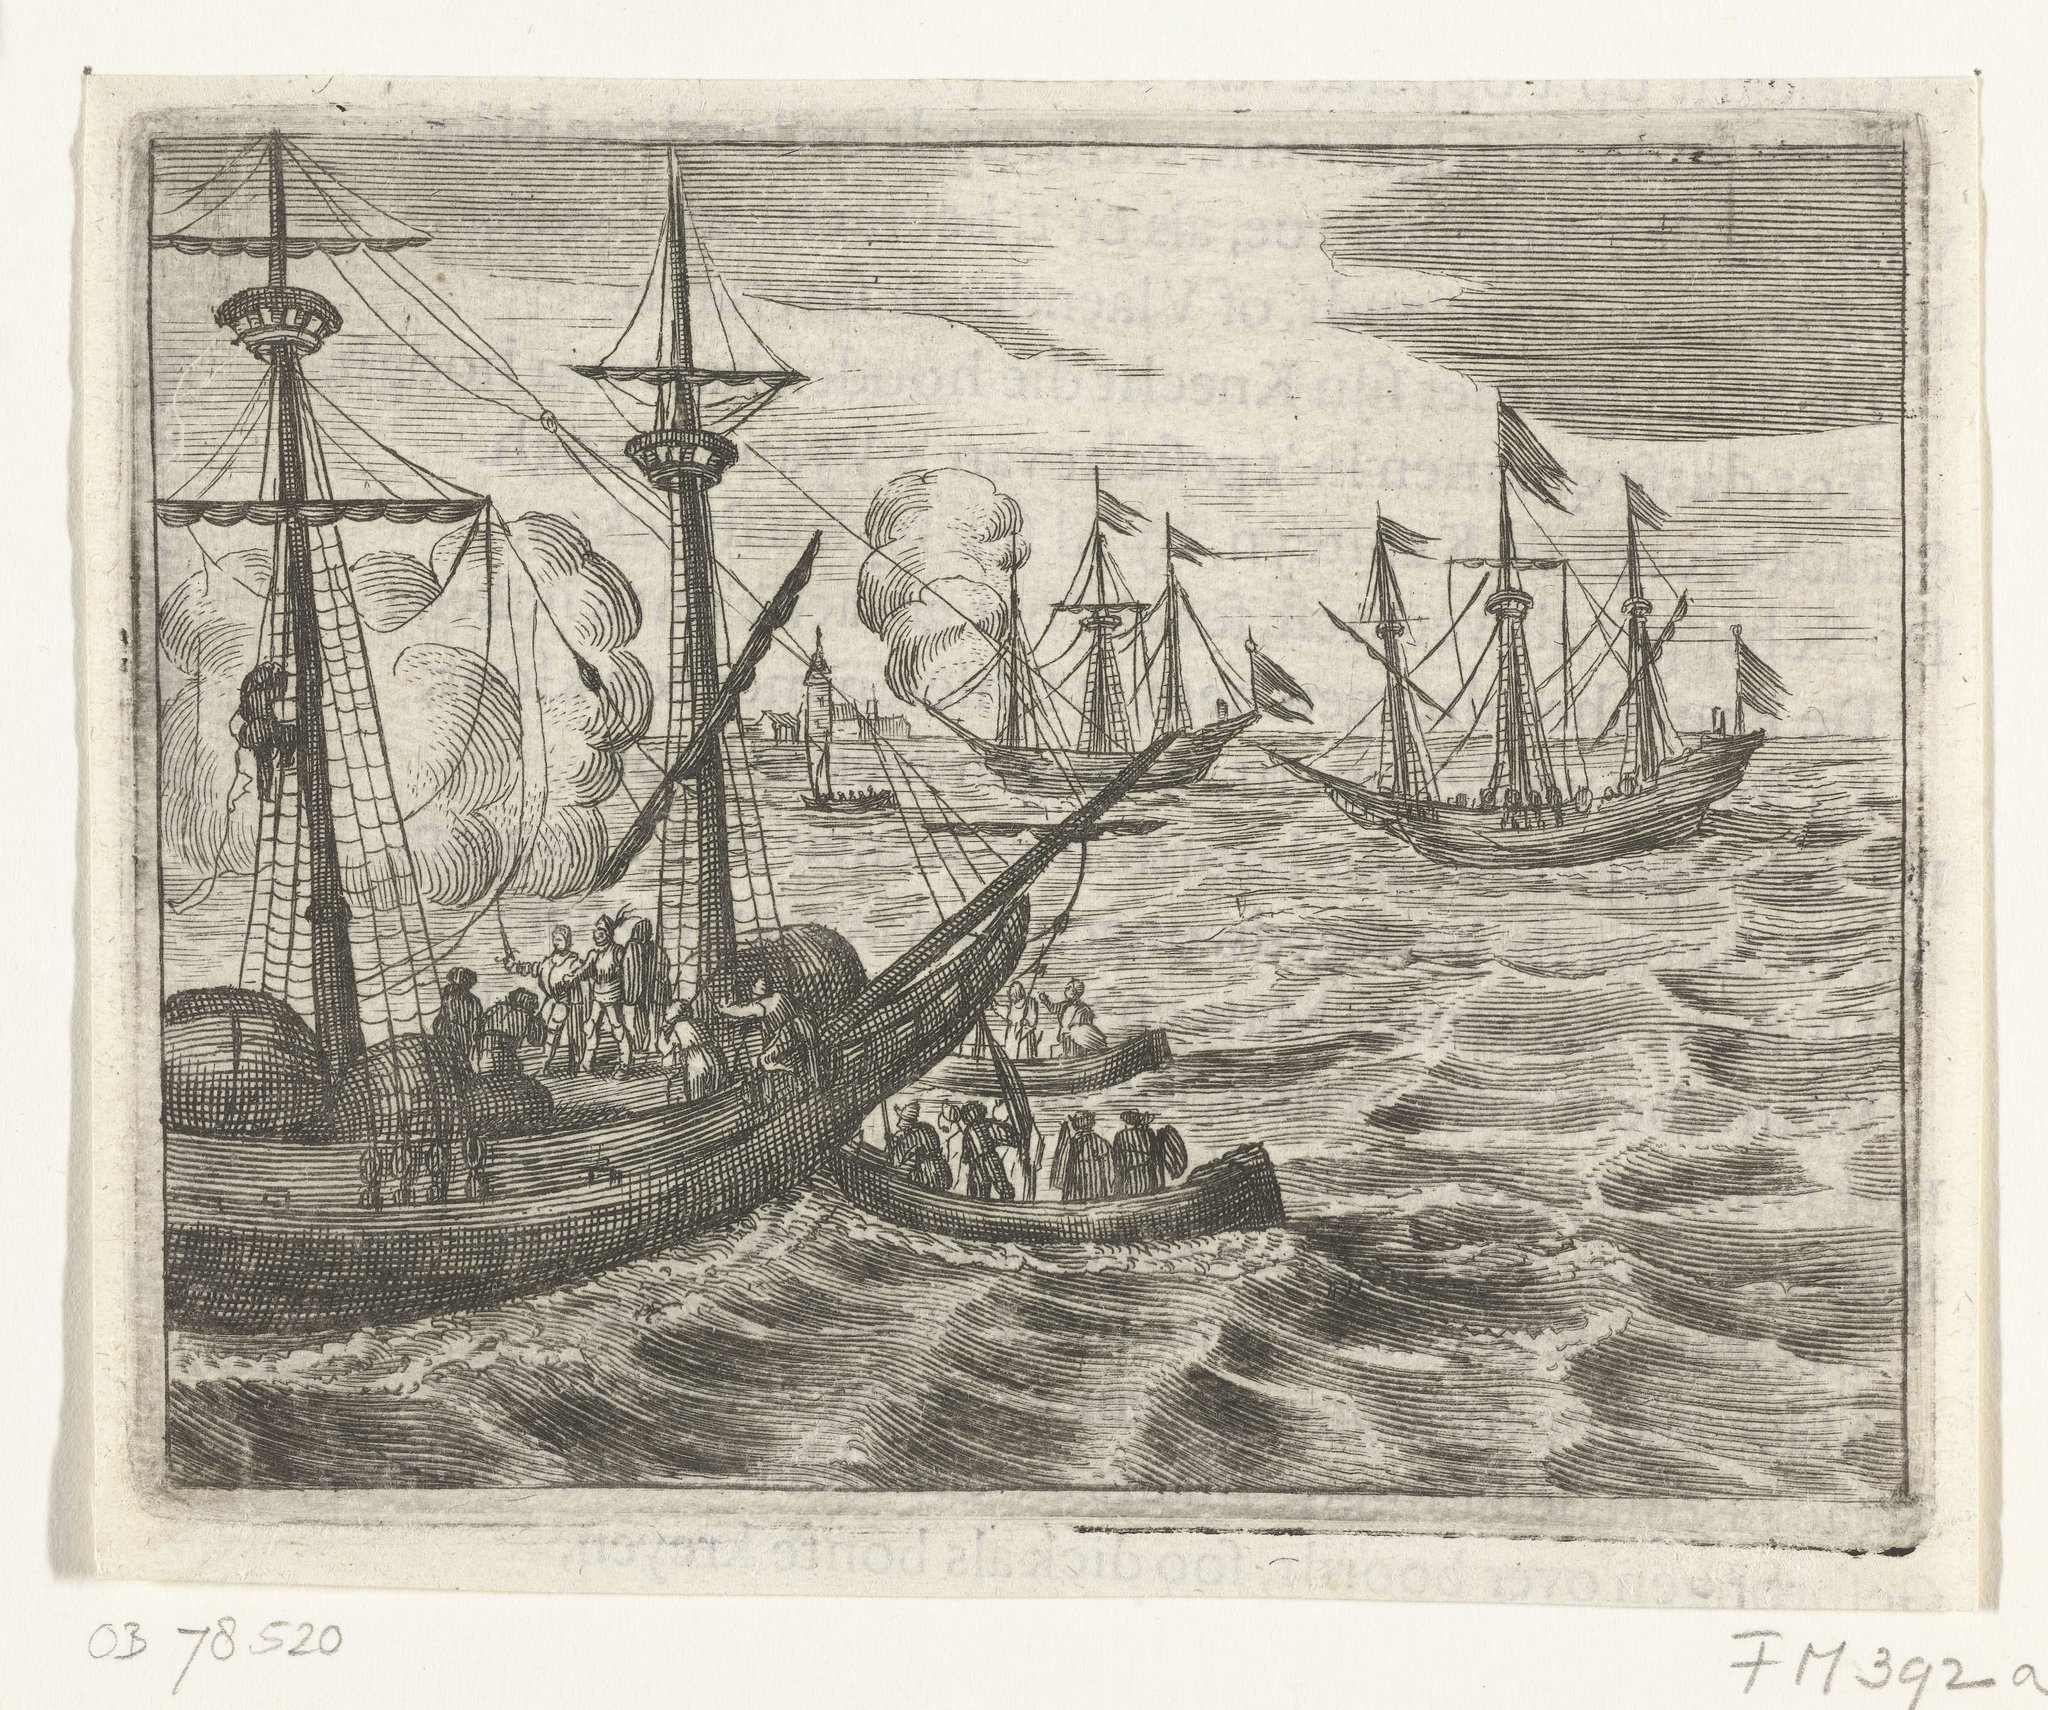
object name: print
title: Twee Fransche Oorloghs-Schepen by die van Dort genoomen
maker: Anonymous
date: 1600-1699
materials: paper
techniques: engraving, etching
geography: northern netherlands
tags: pirate(ship), dordrecht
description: Illustratie uit een onbekend werk. Titel op achterzijde van de prent. Niet in Frederik Muller; door het RPK toegevoegd nummer.